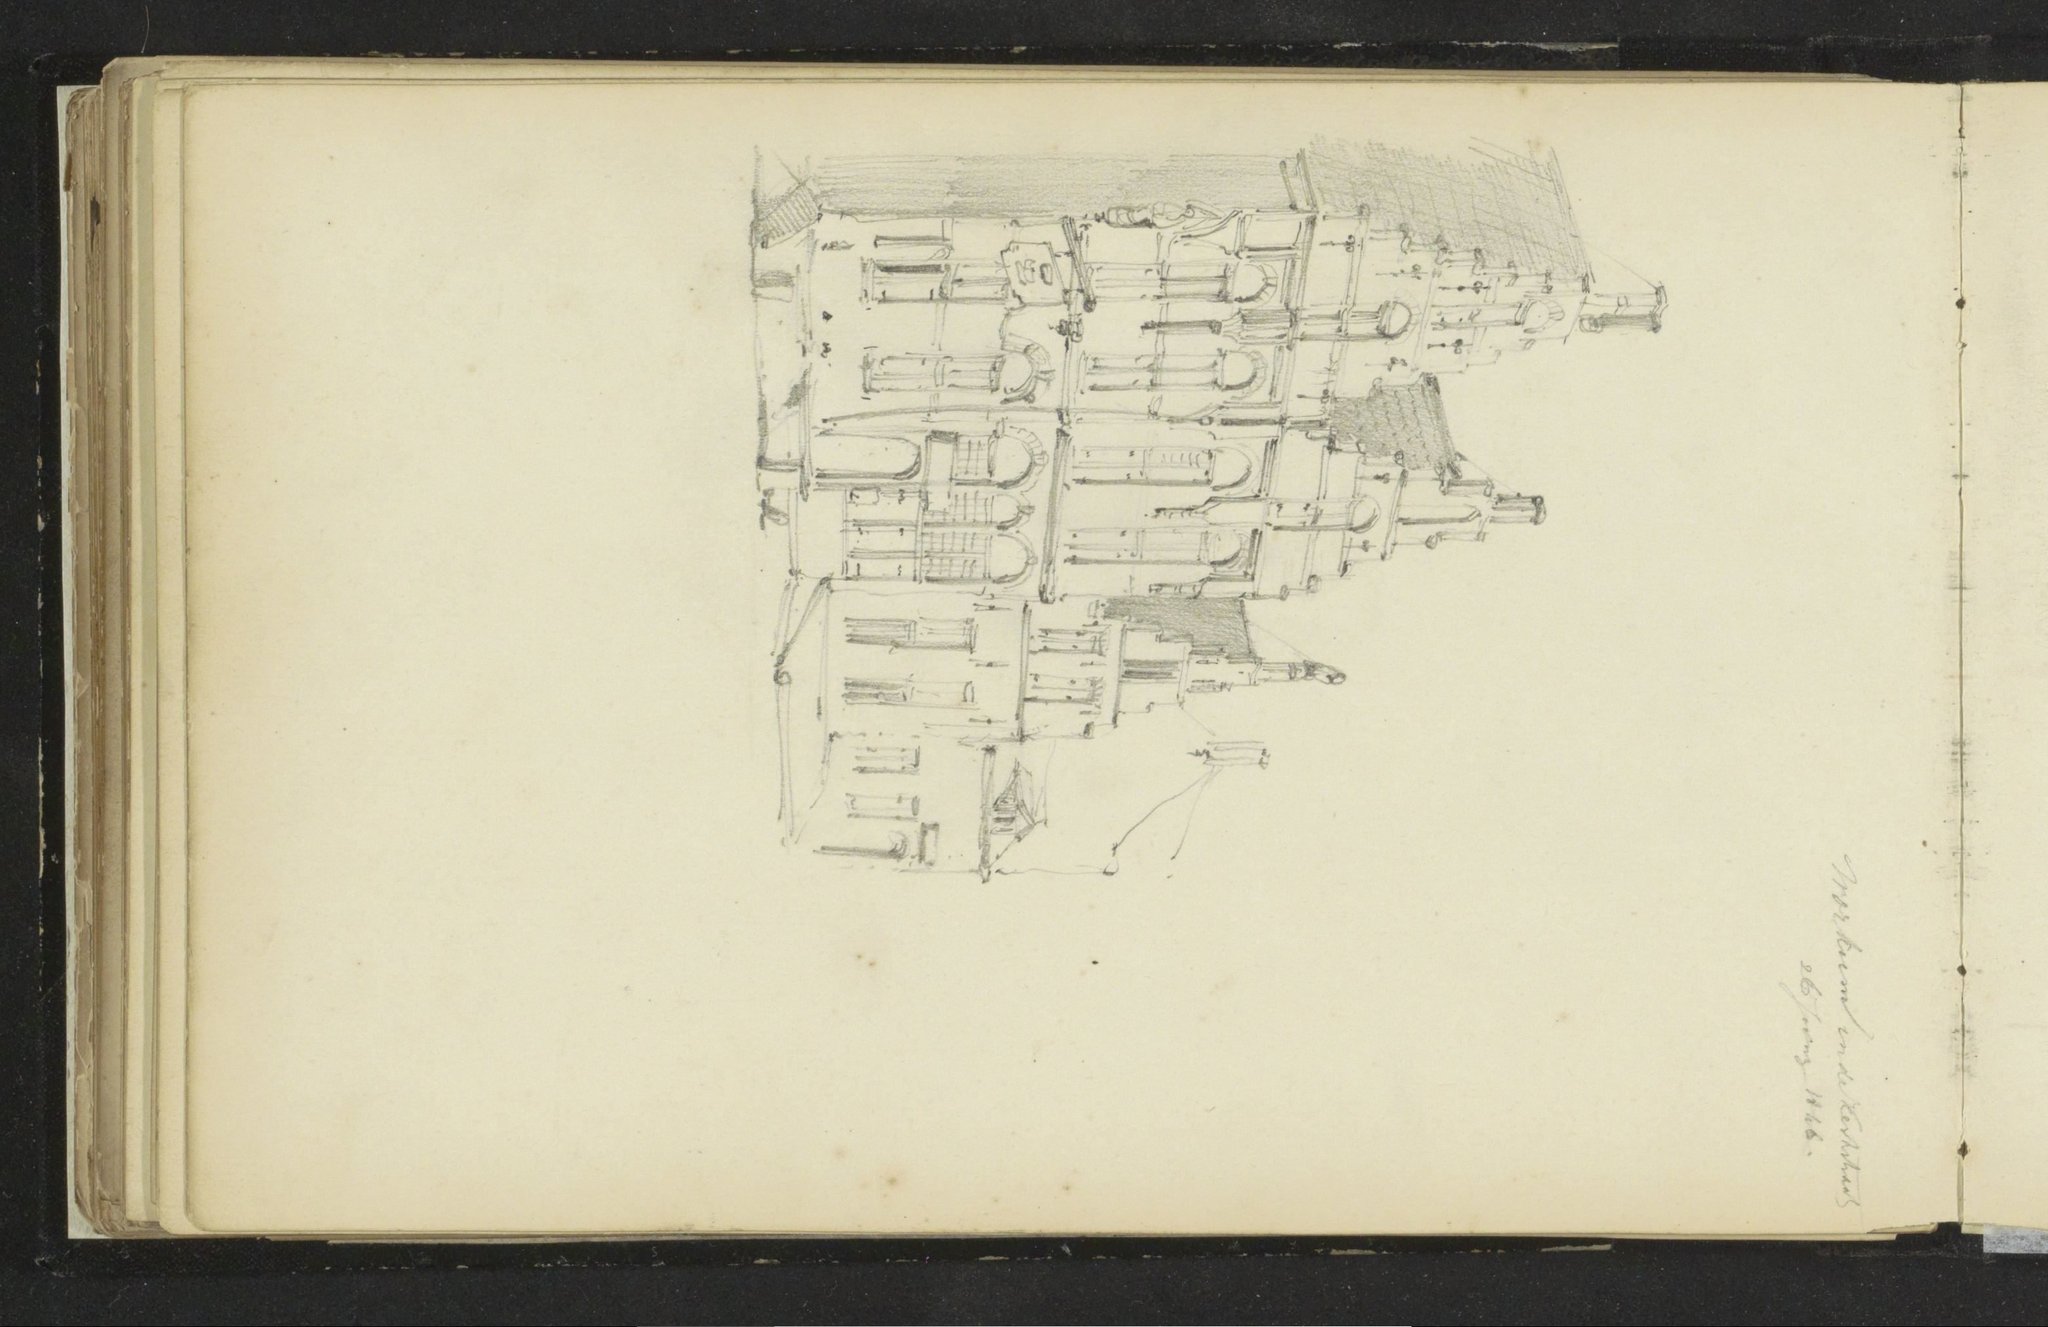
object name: sketchbook leaf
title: Gezicht op gebouwen in de Kerkstraat te Workum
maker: cornelis springer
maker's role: draughtsman, painter, print maker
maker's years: 1817-1891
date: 1846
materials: paper, pencil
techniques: stumping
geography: workum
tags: urban housing, street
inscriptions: annotation: ‘Workum in de Kerkstraat’, date: ‘26 juny 1846’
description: Gezicht op gebouwen in de Kerkstraat te Workum. Blad 86 verso uit een schetsboek met 91 bladen.